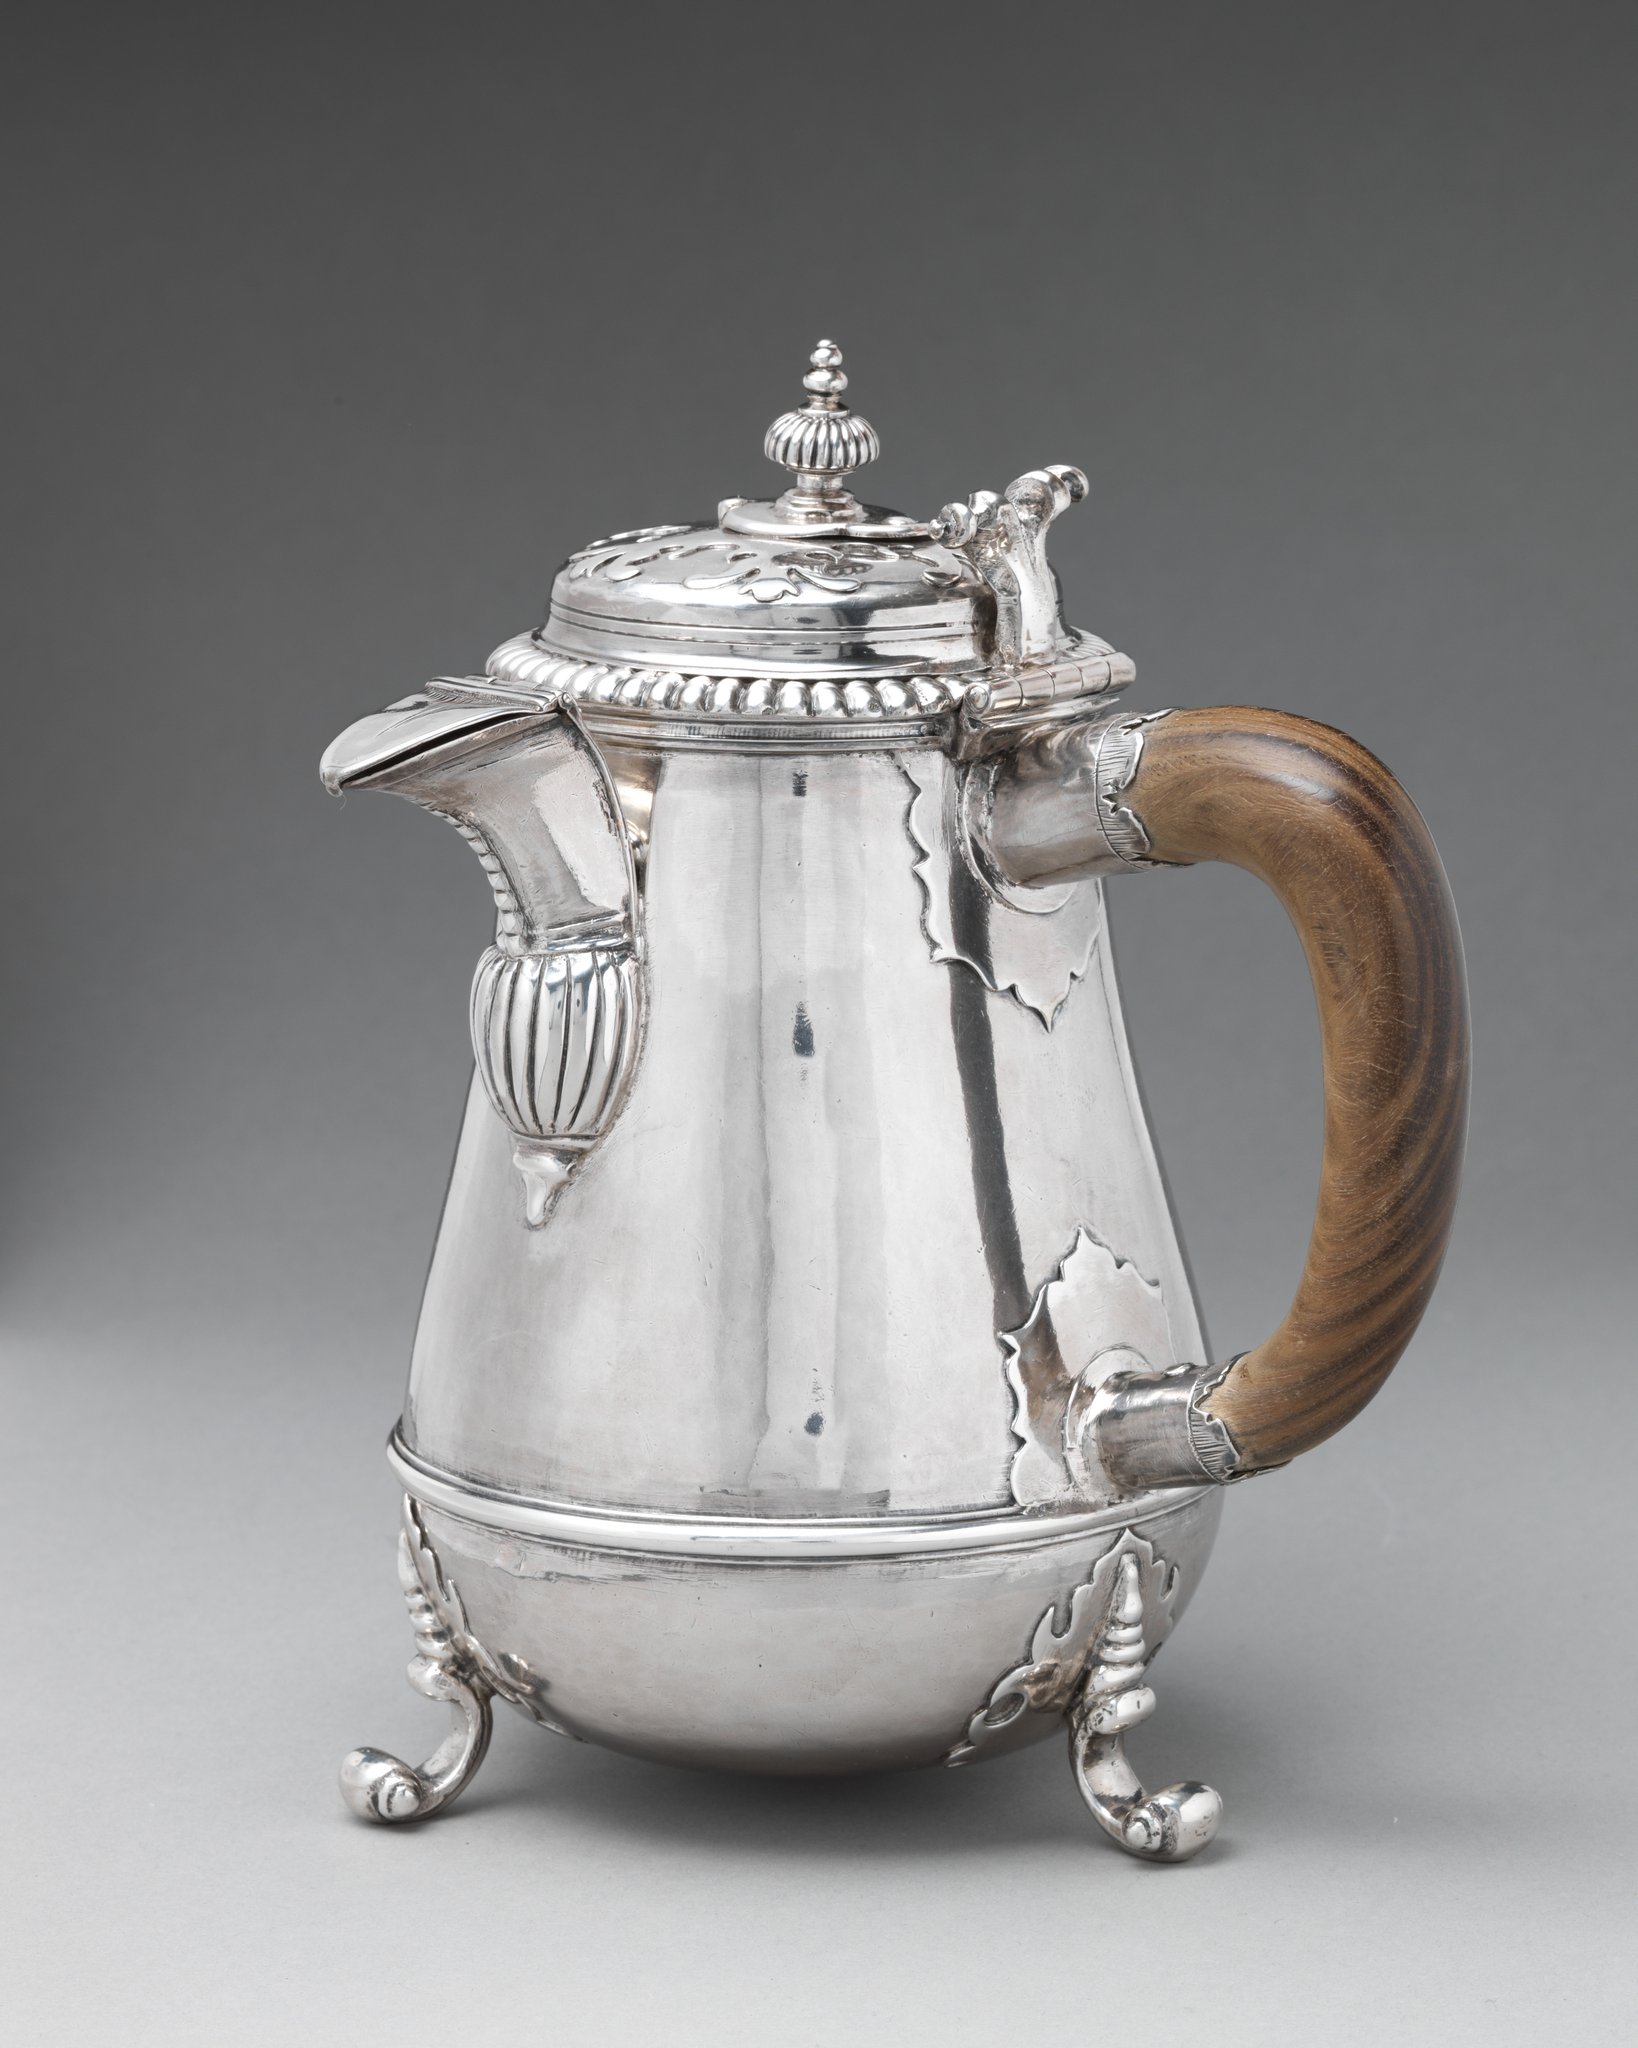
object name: chocolate pot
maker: benjamin bradford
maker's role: maker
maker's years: 1697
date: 1697-1698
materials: silver, wood